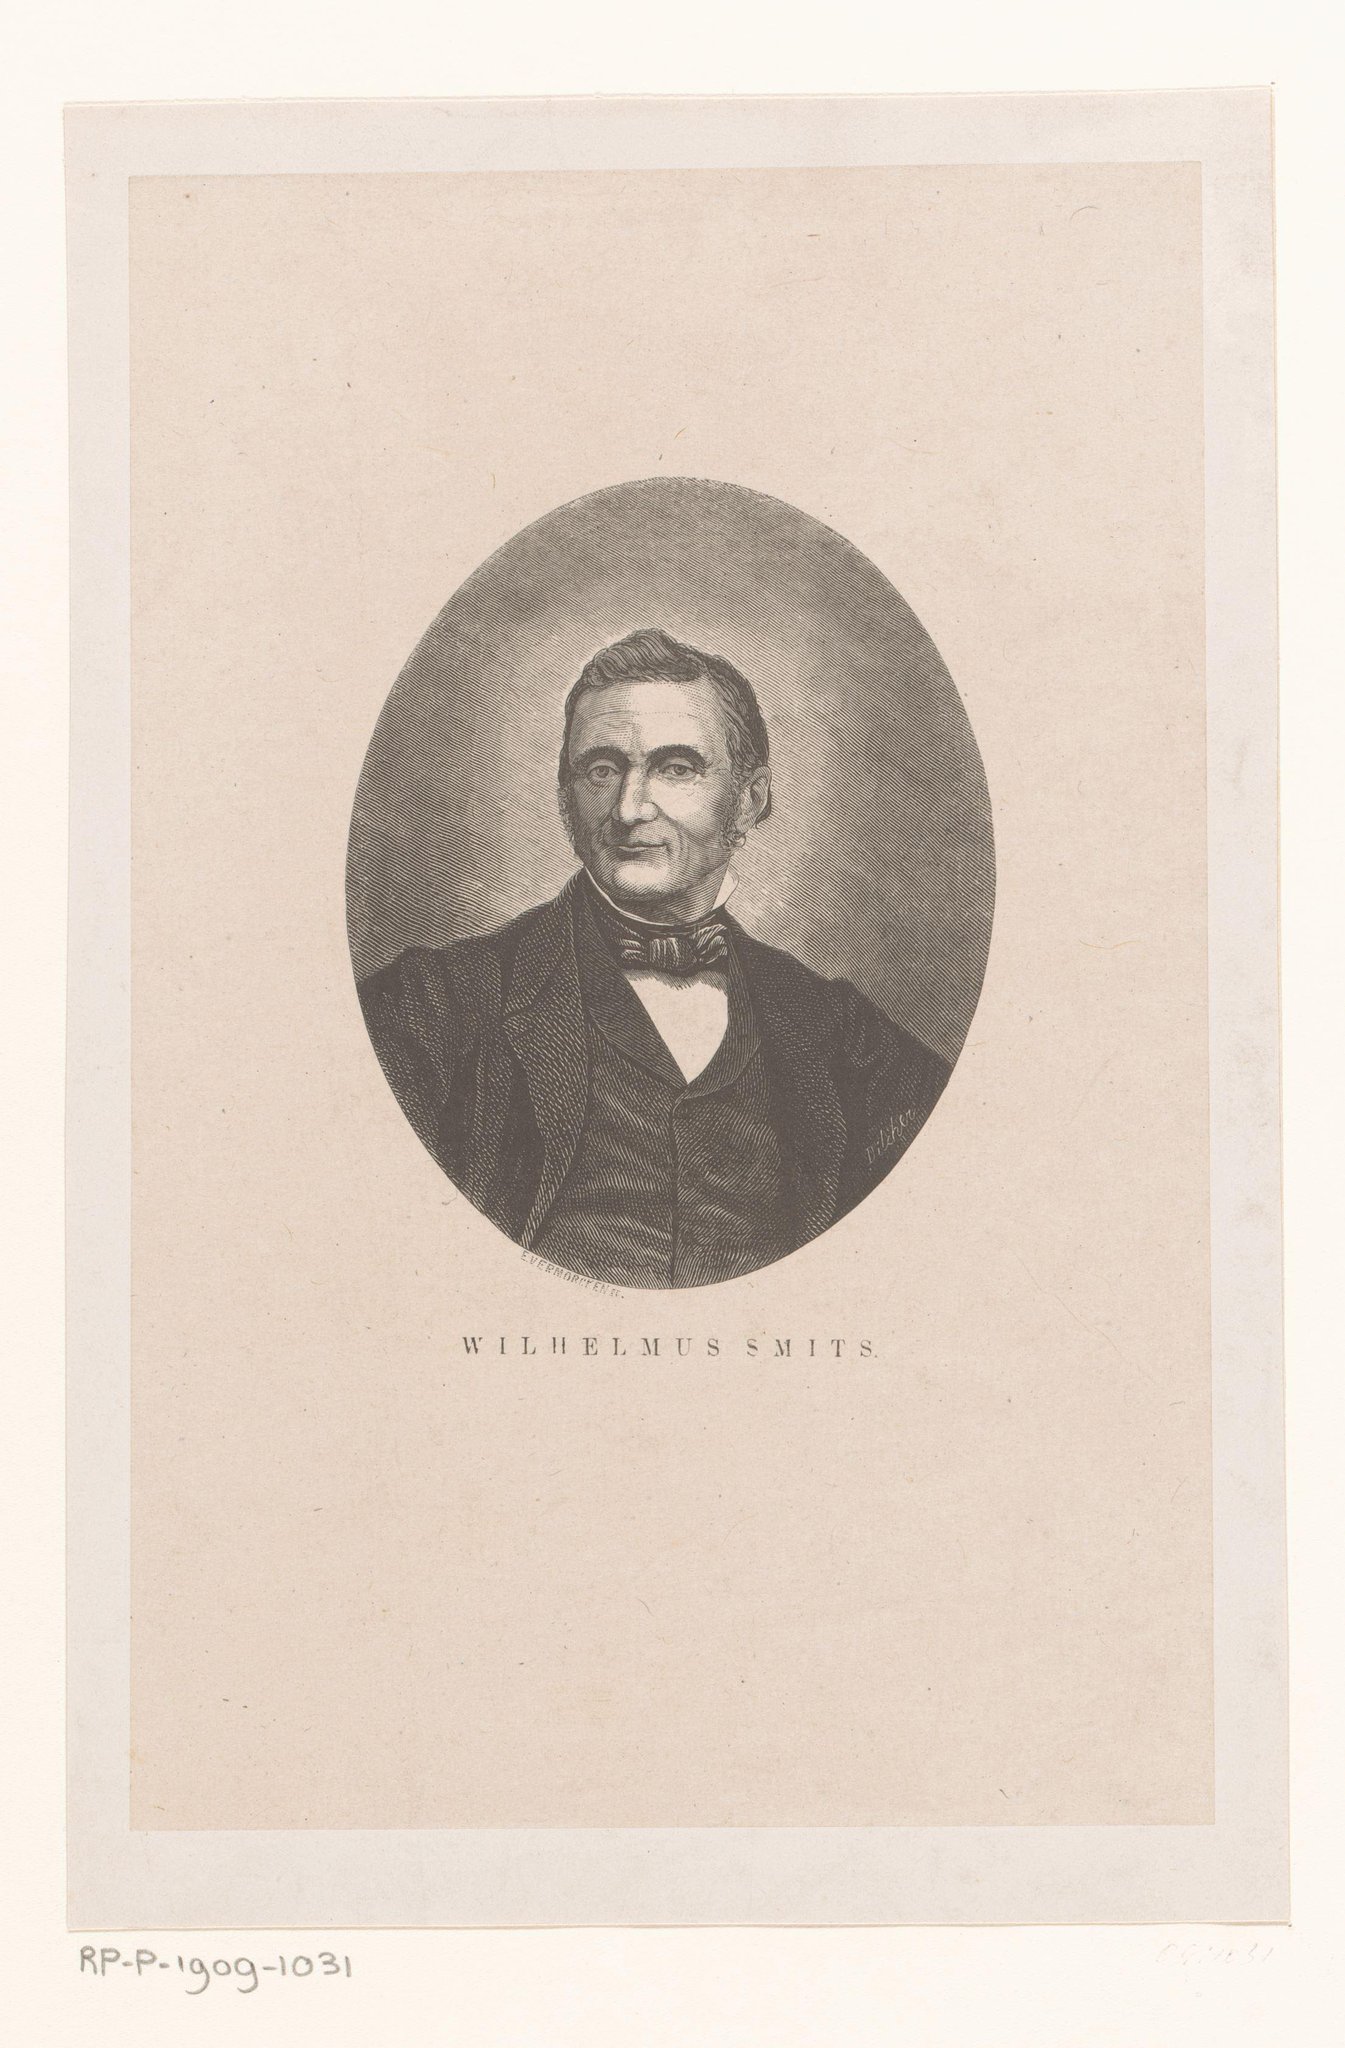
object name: print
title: Portret van Wilhelmus Smits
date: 1830-1906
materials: paper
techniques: engraving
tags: historical persons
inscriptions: collector's mark: Lugt 2228